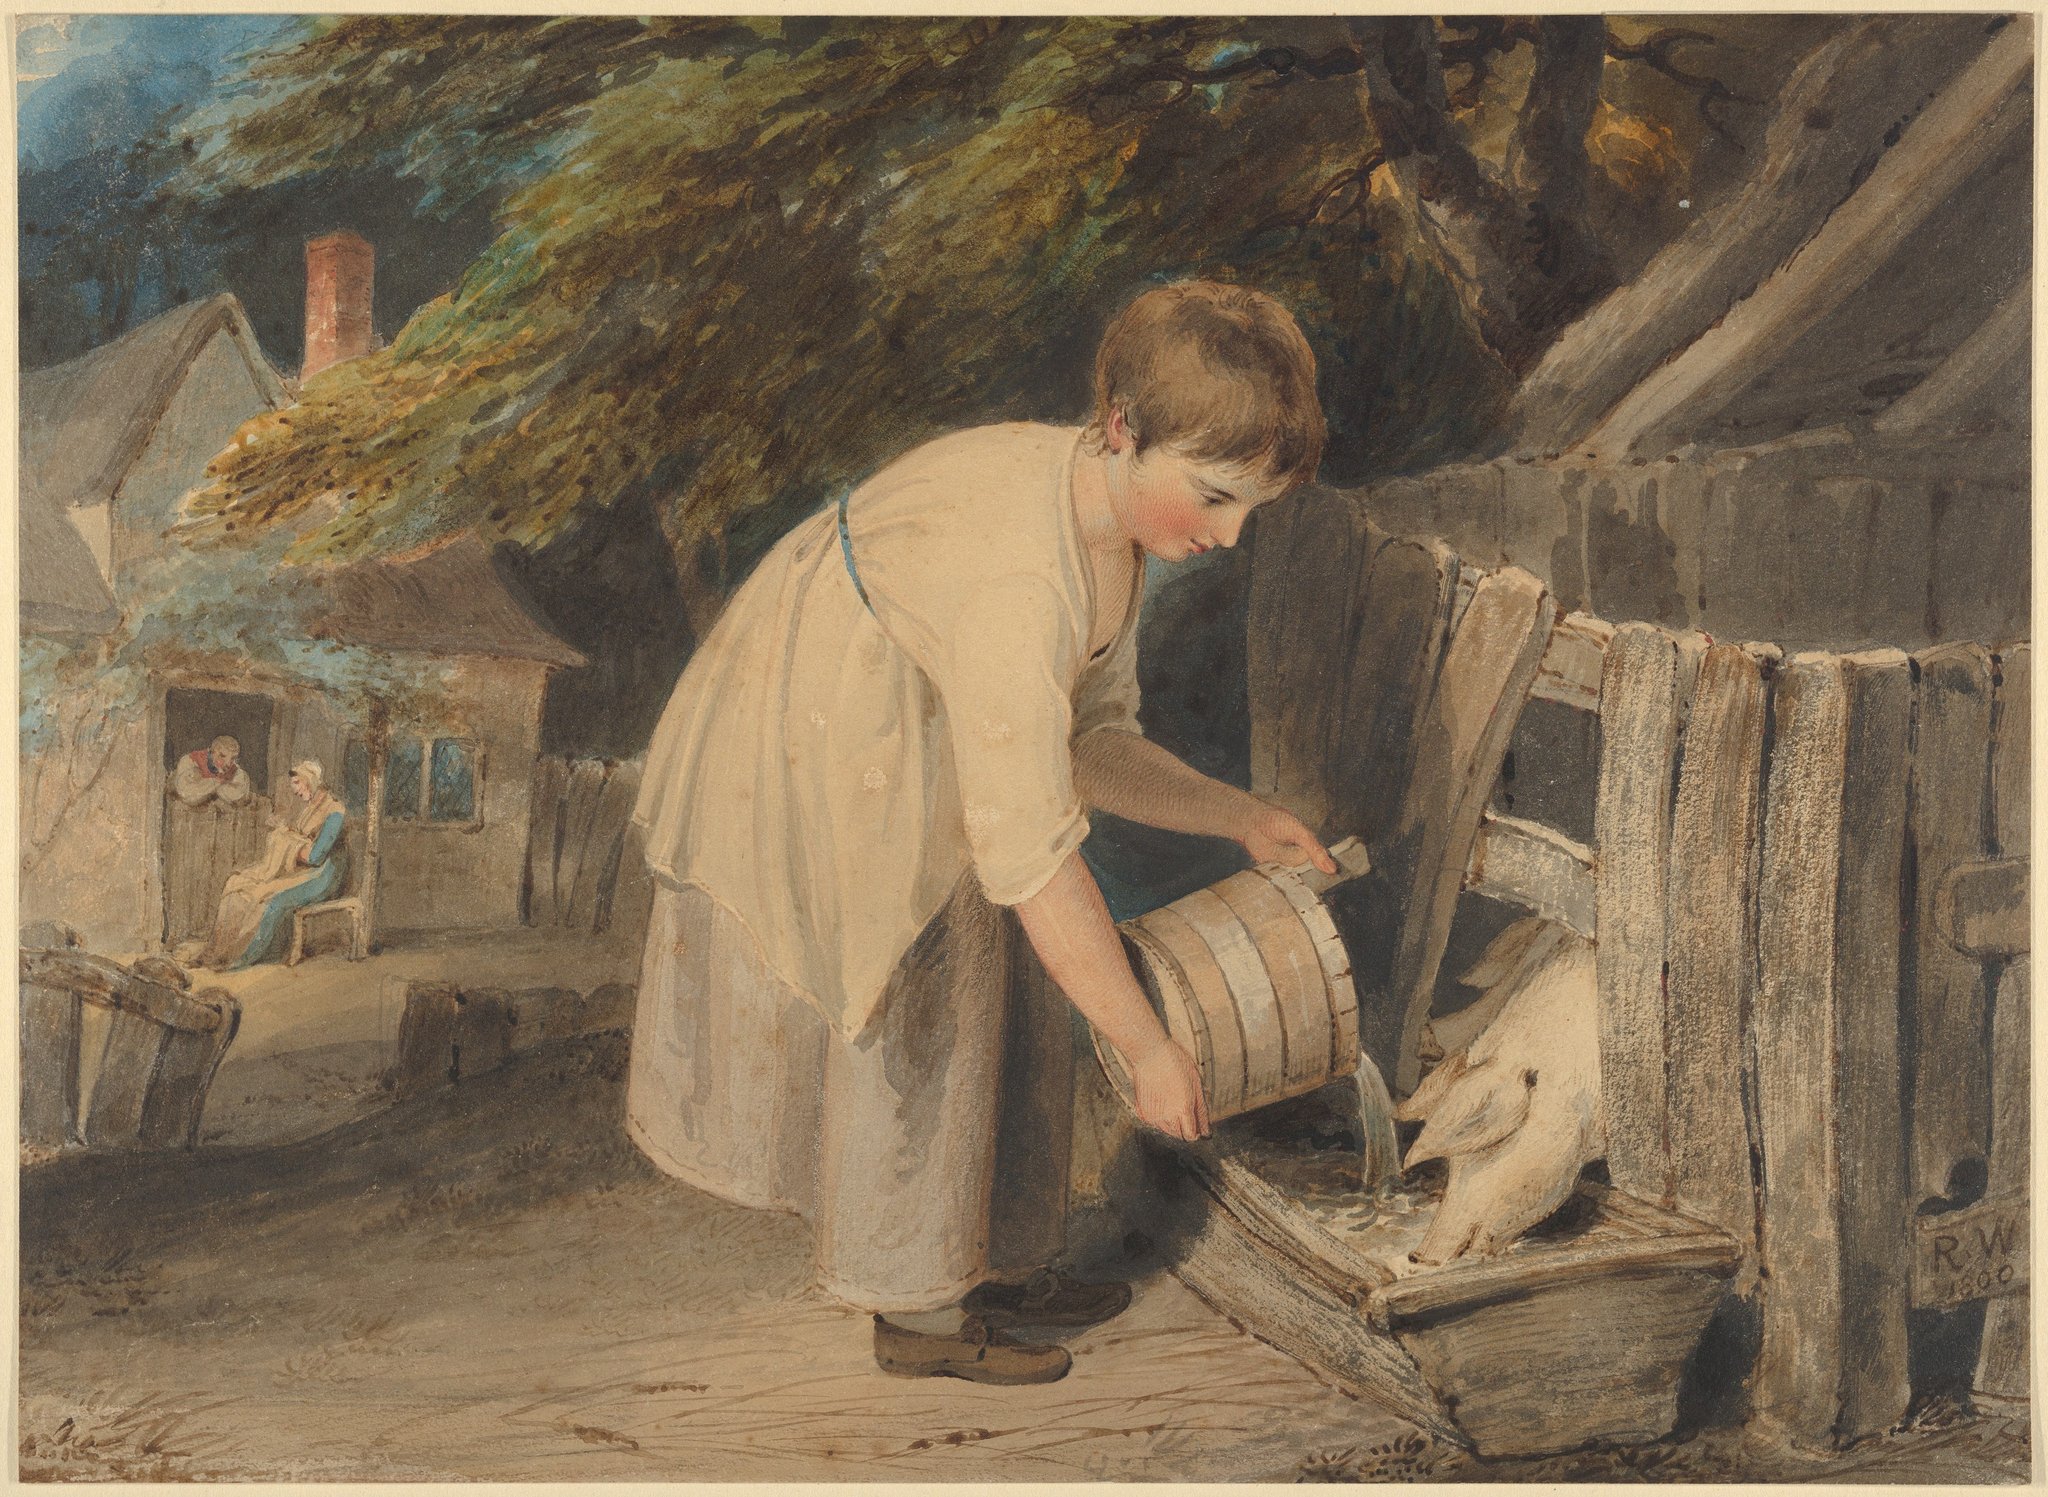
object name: drawing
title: Girl Feeding Pigs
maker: richard westall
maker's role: artist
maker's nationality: british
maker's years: 1765-1836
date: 1800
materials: watercolor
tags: girls,pigs,buckets